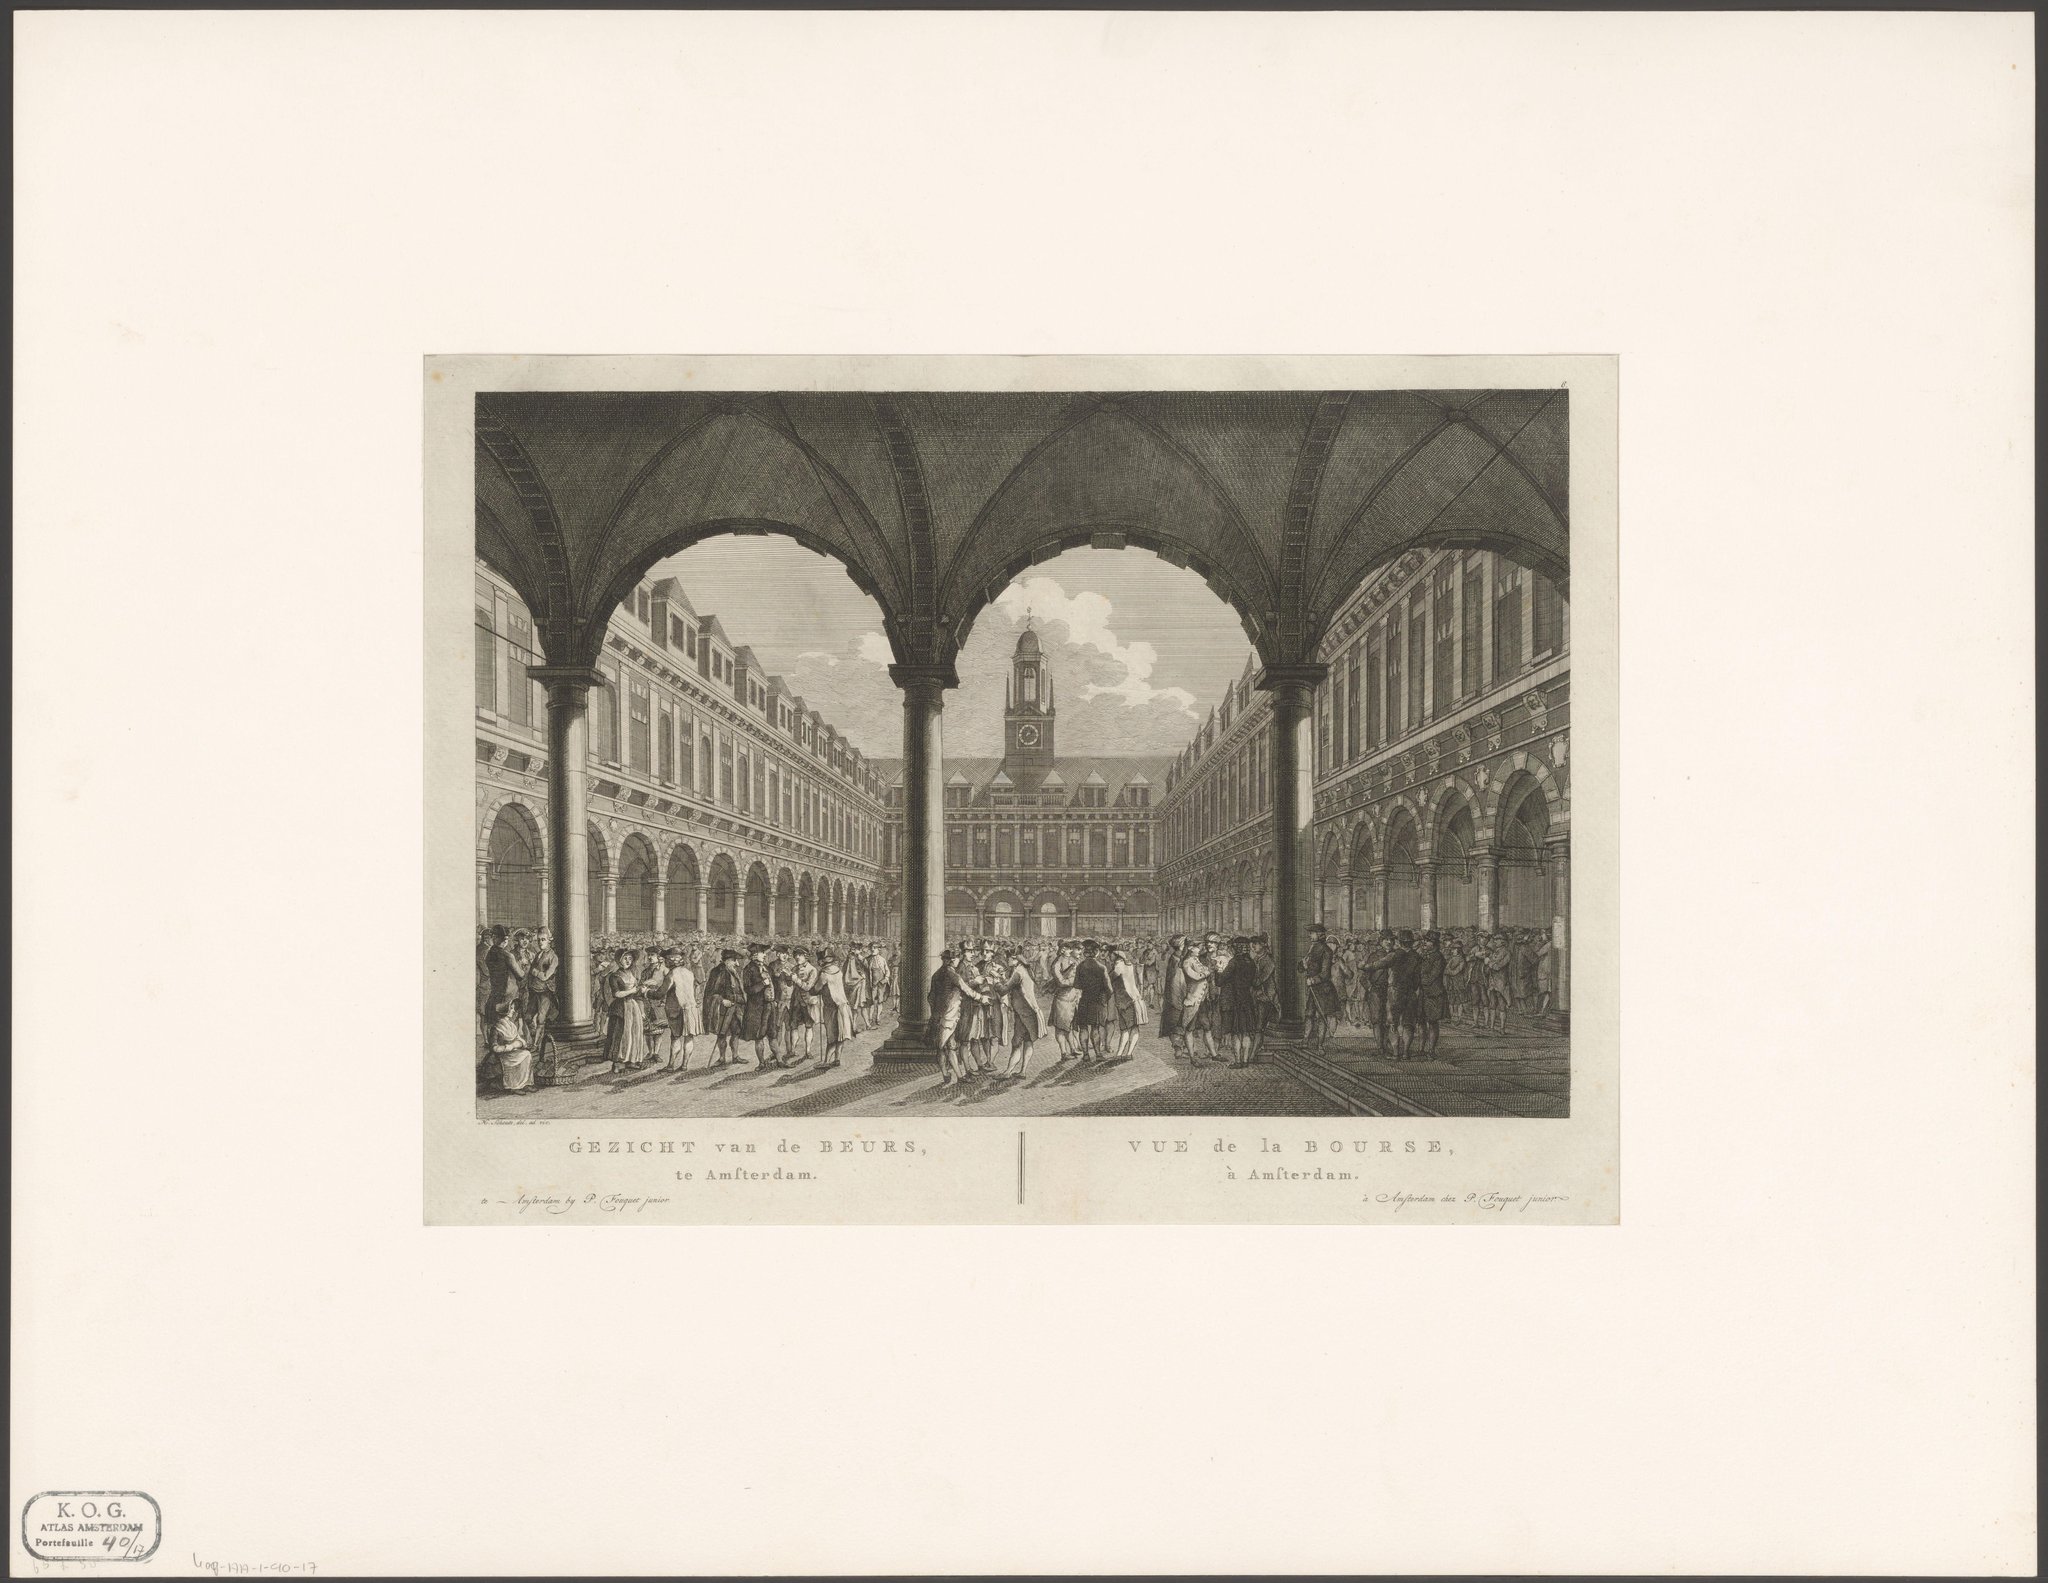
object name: print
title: Gezicht van de Beurs, te Amsterdam / Vue de la Bourse, à Amsterdam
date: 1770-1783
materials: paper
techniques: engraving, etching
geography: amsterdam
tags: stock exchange, stock-market, courtyard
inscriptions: collector's mark: Lugt 1641b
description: Vanaf 1760 gaf Pierre Fouquet stadsgezichten van Amsterdam naar tekeningen van verschillende kunstenaars uit. Deze prenten werden aanvankelijk los verkocht. Later werden ze samengebonden verkocht in verschillende volgordes en aantallen in: (1). Afbeeldingen van de wyd-vermaarde koopstad Amsterdam benevens des zelvs voornaamste gebouwen en gezigten alle naar het leeven getekend / Receuil des edifices les plus considerables et des plus belles vues, de la fameuse ville d'Amsterdam, dessinées d'après nature. Amsterdam: Pierre Fouquet, 1778-1783. Deze 'uitgave' bestond waarschijnlijk alleen uit een titelblad en inhoudsopgave van de tot dusver 100 uitgegeven prenten, die de koper zelf aan zijn of haar reeds verzamelde prenten kon toevoegen. De hoeveelheid en volgorde van prenten verzameld onder deze titel verschilt dus sterk. (2). Nieuwe atlas, van de voornaamste gebouwen en gezigten der stad Amsterdam, met derzelver beknopte beschryvingen. 2 dln. Amsterdam: Daniël Jean Changuion en Petrus den Hengst [in opdracht van Pierre Fouquet], 1783. Ook werden er door verschillende uitgevers tussen 1788 (Amsterdam: Petrus Conradi) en 1805 (Amsterdam: Evert Maaskamp) heruitgaven gepubliceerd.